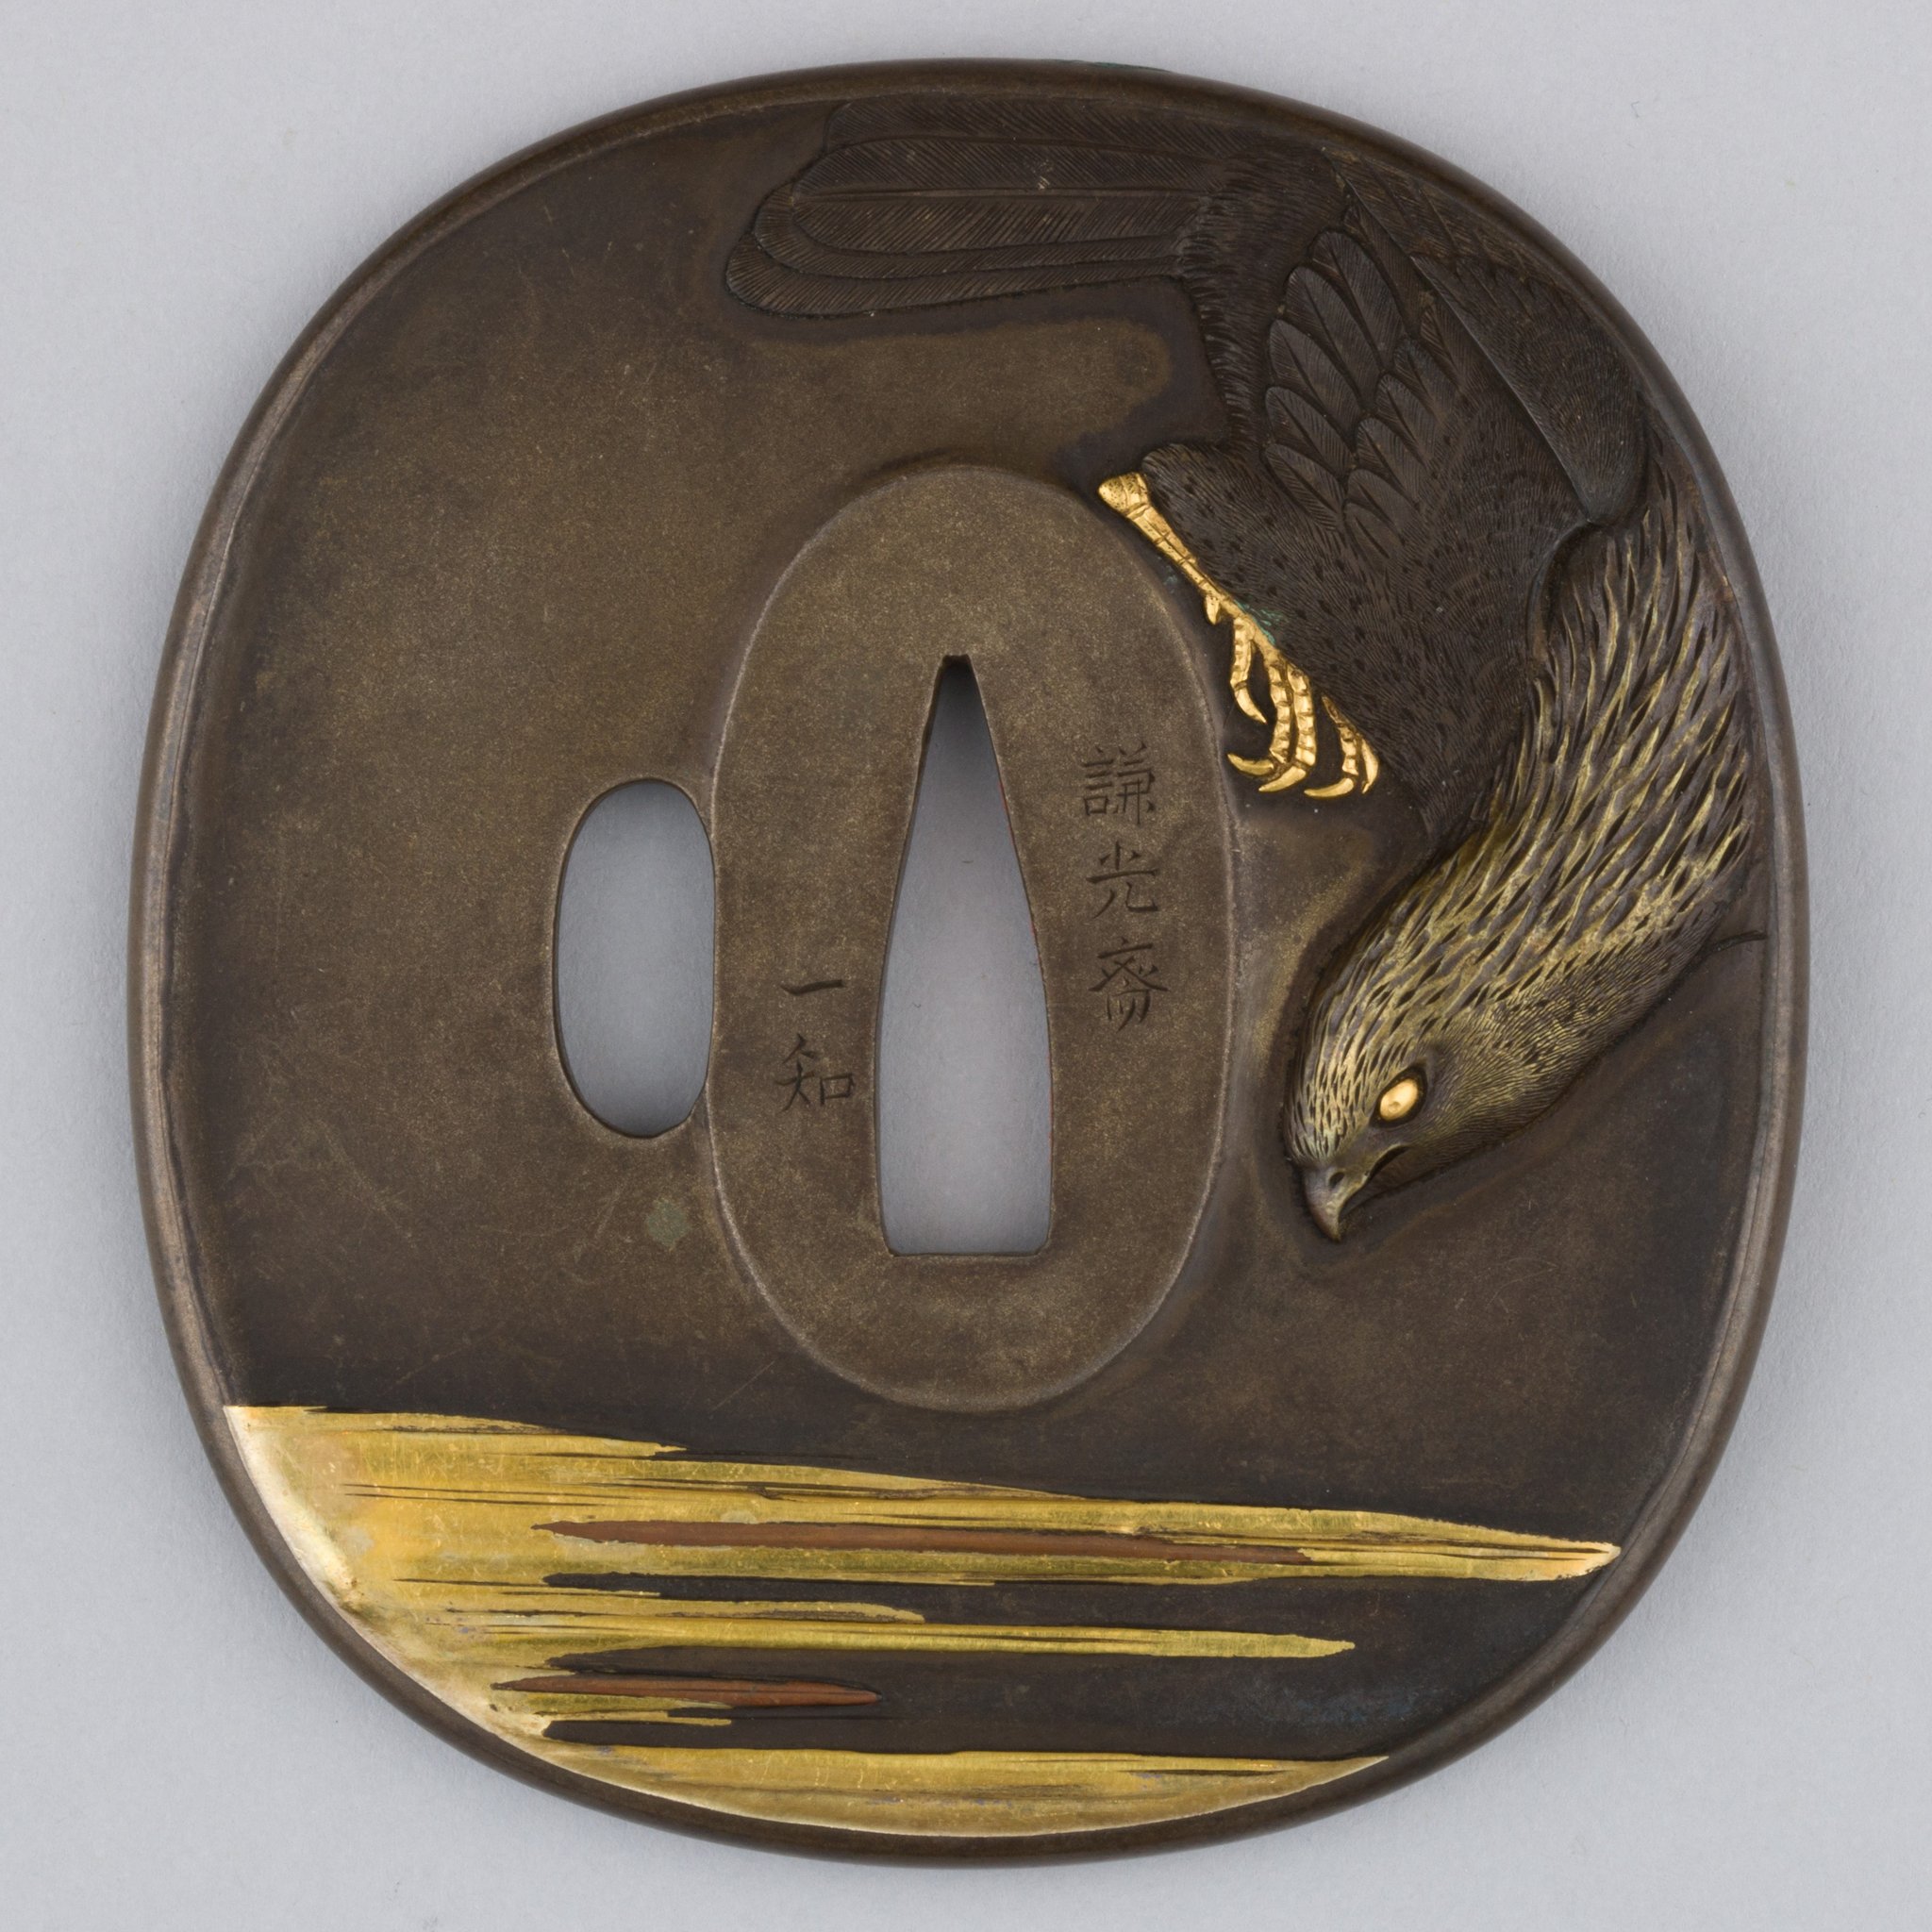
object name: sword guard tsuba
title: Sword Guard (Tsuba)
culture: japanese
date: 1615-1868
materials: copper, gold alloy, silver alloy, gold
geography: japan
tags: birds